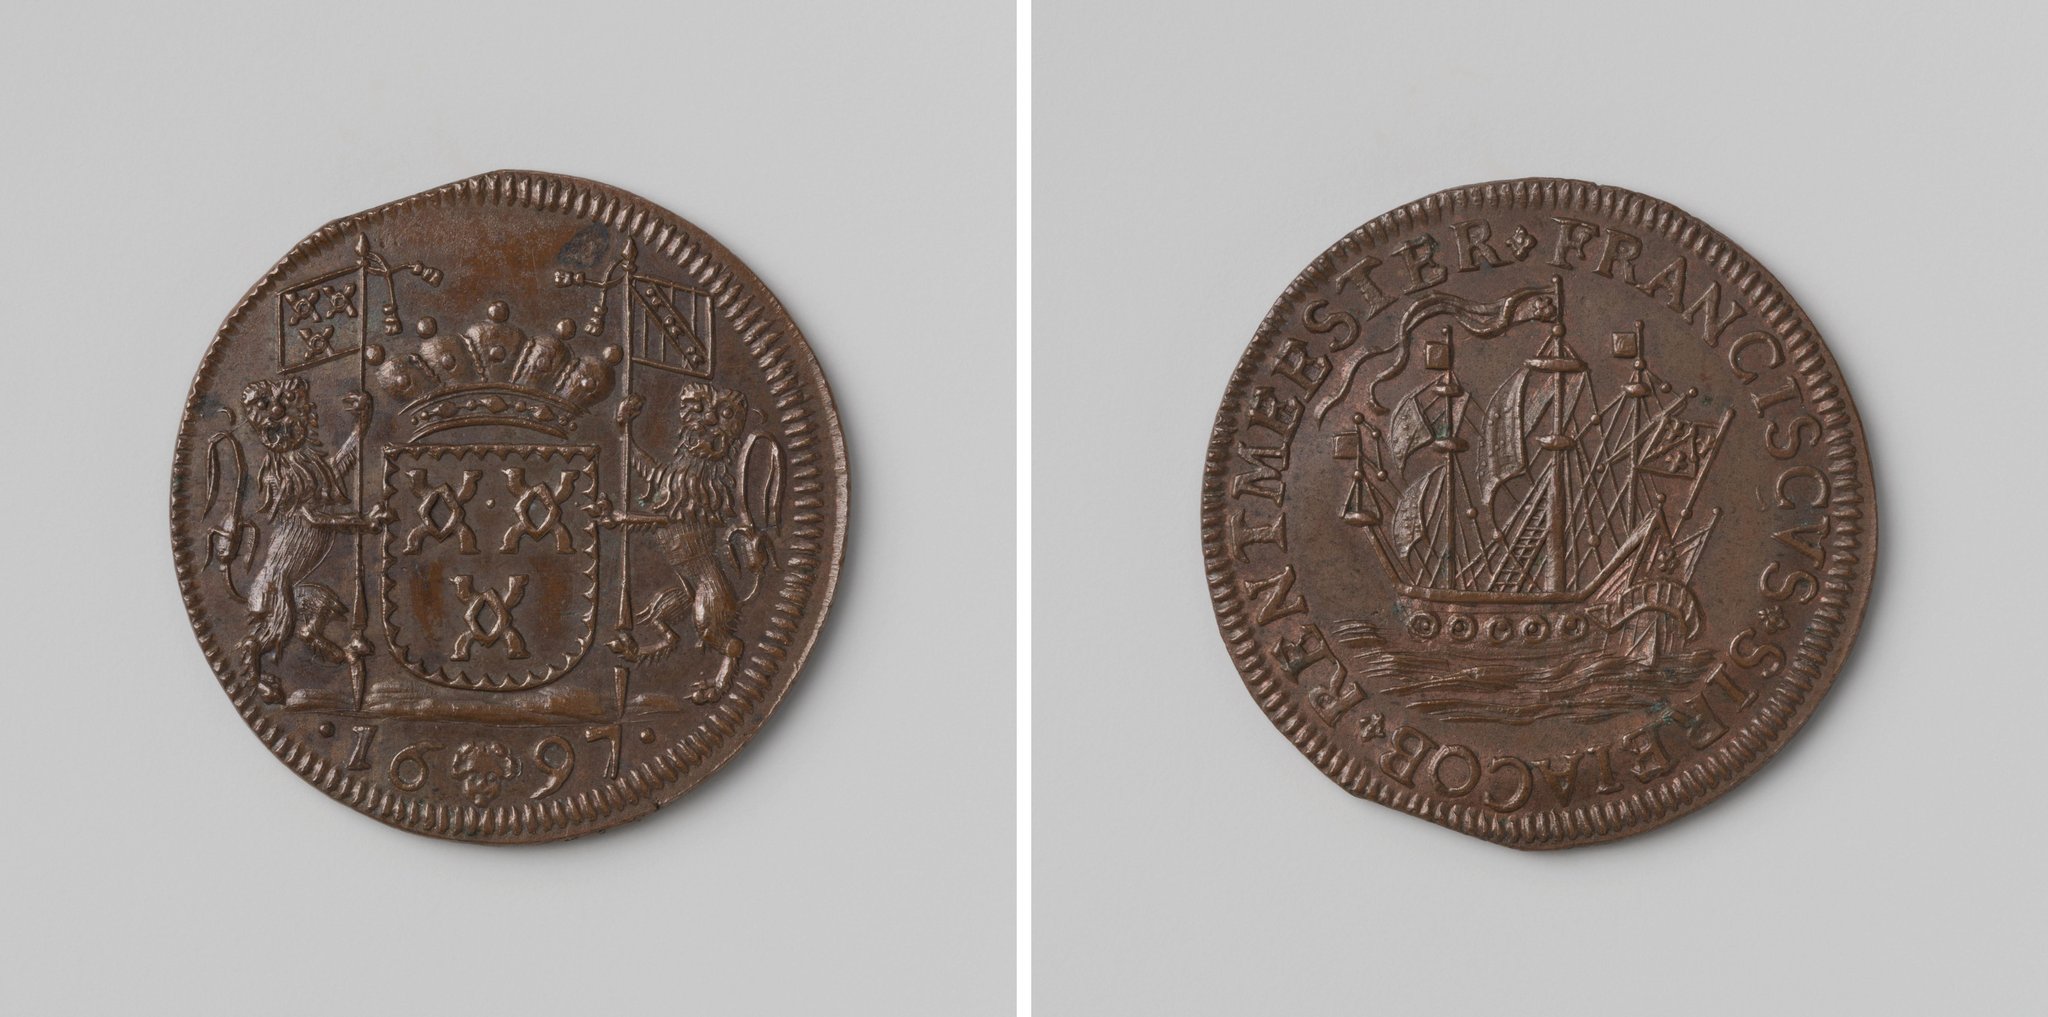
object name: jeton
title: Jean Jacques de Brouckhoven, negenenvijftigste intendant van de Brusselse vaart en Francois Sirejacob, rentmeester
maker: Anonymous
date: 1601-1697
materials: copper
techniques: striking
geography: brussels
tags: jean jacques de brouckhoven (baron van putte), francois sirejacob, willebroekse vaart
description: Koperen penning. Voorzijde: gekroond wapenschild, geflankeerd door twee leeuwen met banier boven jaartal. Keerzijde: schip op water binnen omschrift